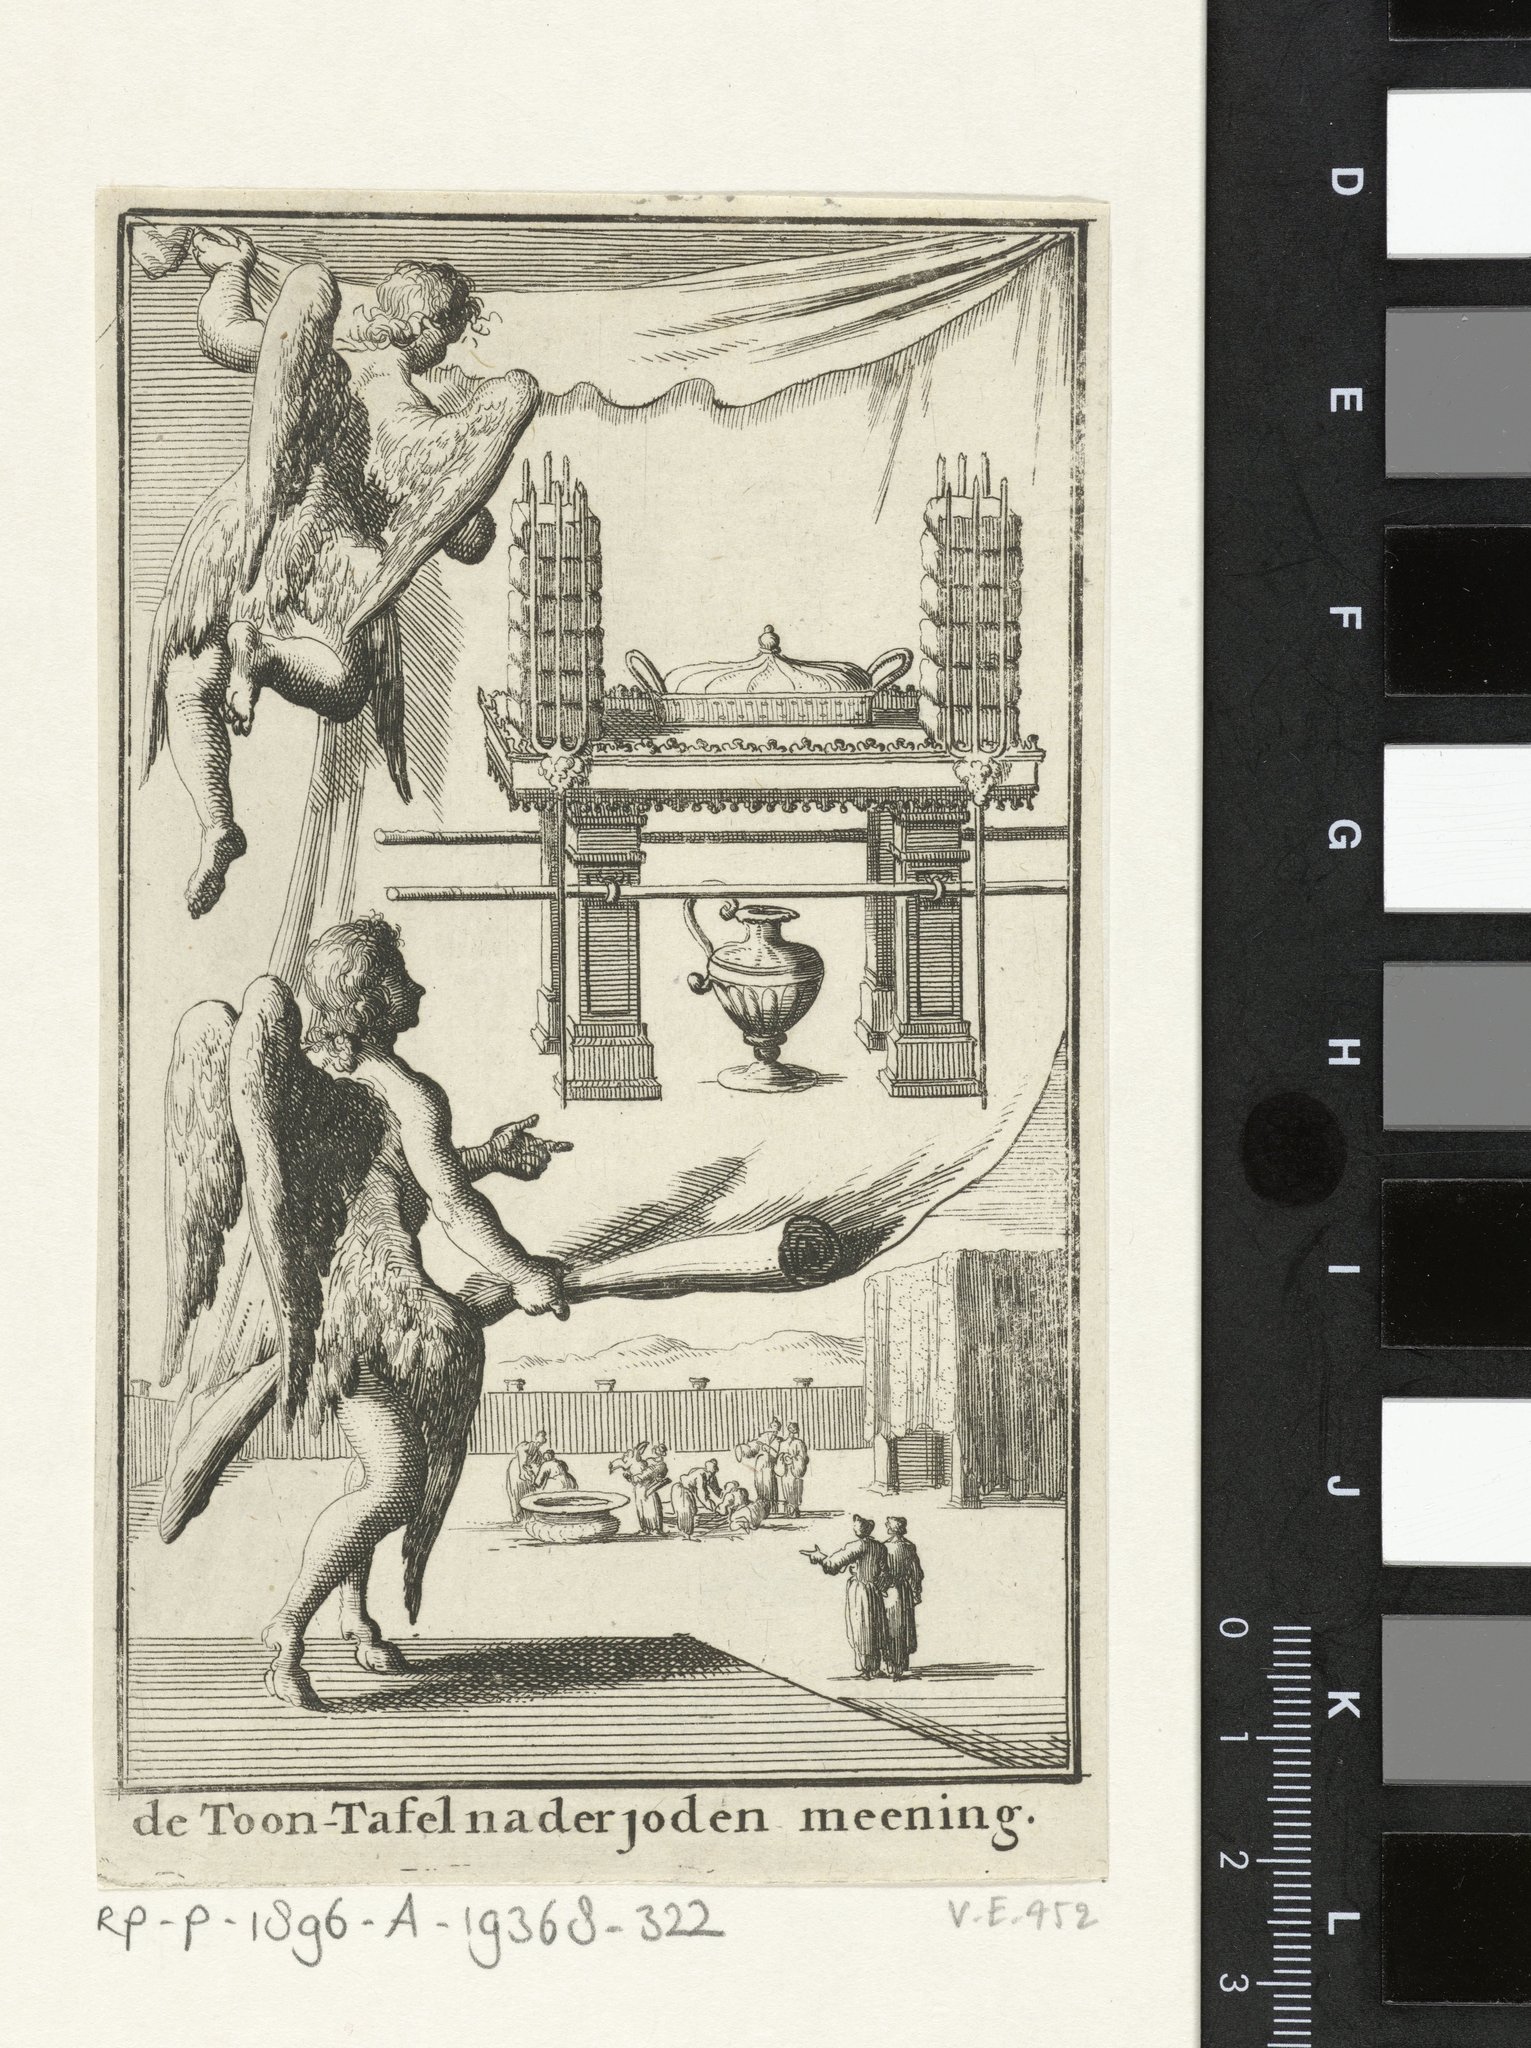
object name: print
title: Engelen bekijken het ontwerp voor de Tafel der Toonbroden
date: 1683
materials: paper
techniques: etching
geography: amsterdam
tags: table of the showbread in the tabernacle ~ jewish religion, architectural design or model, angels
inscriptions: collector's mark: Lugt 2228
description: Illustratie opgenomen in: Cunaeus, Petrus. De republyk der Hebreen, of gemeenebest der joden, 3 delen. Amsterdam: Wilhelmus Goeree, 1683, dl. 2, p. 339.